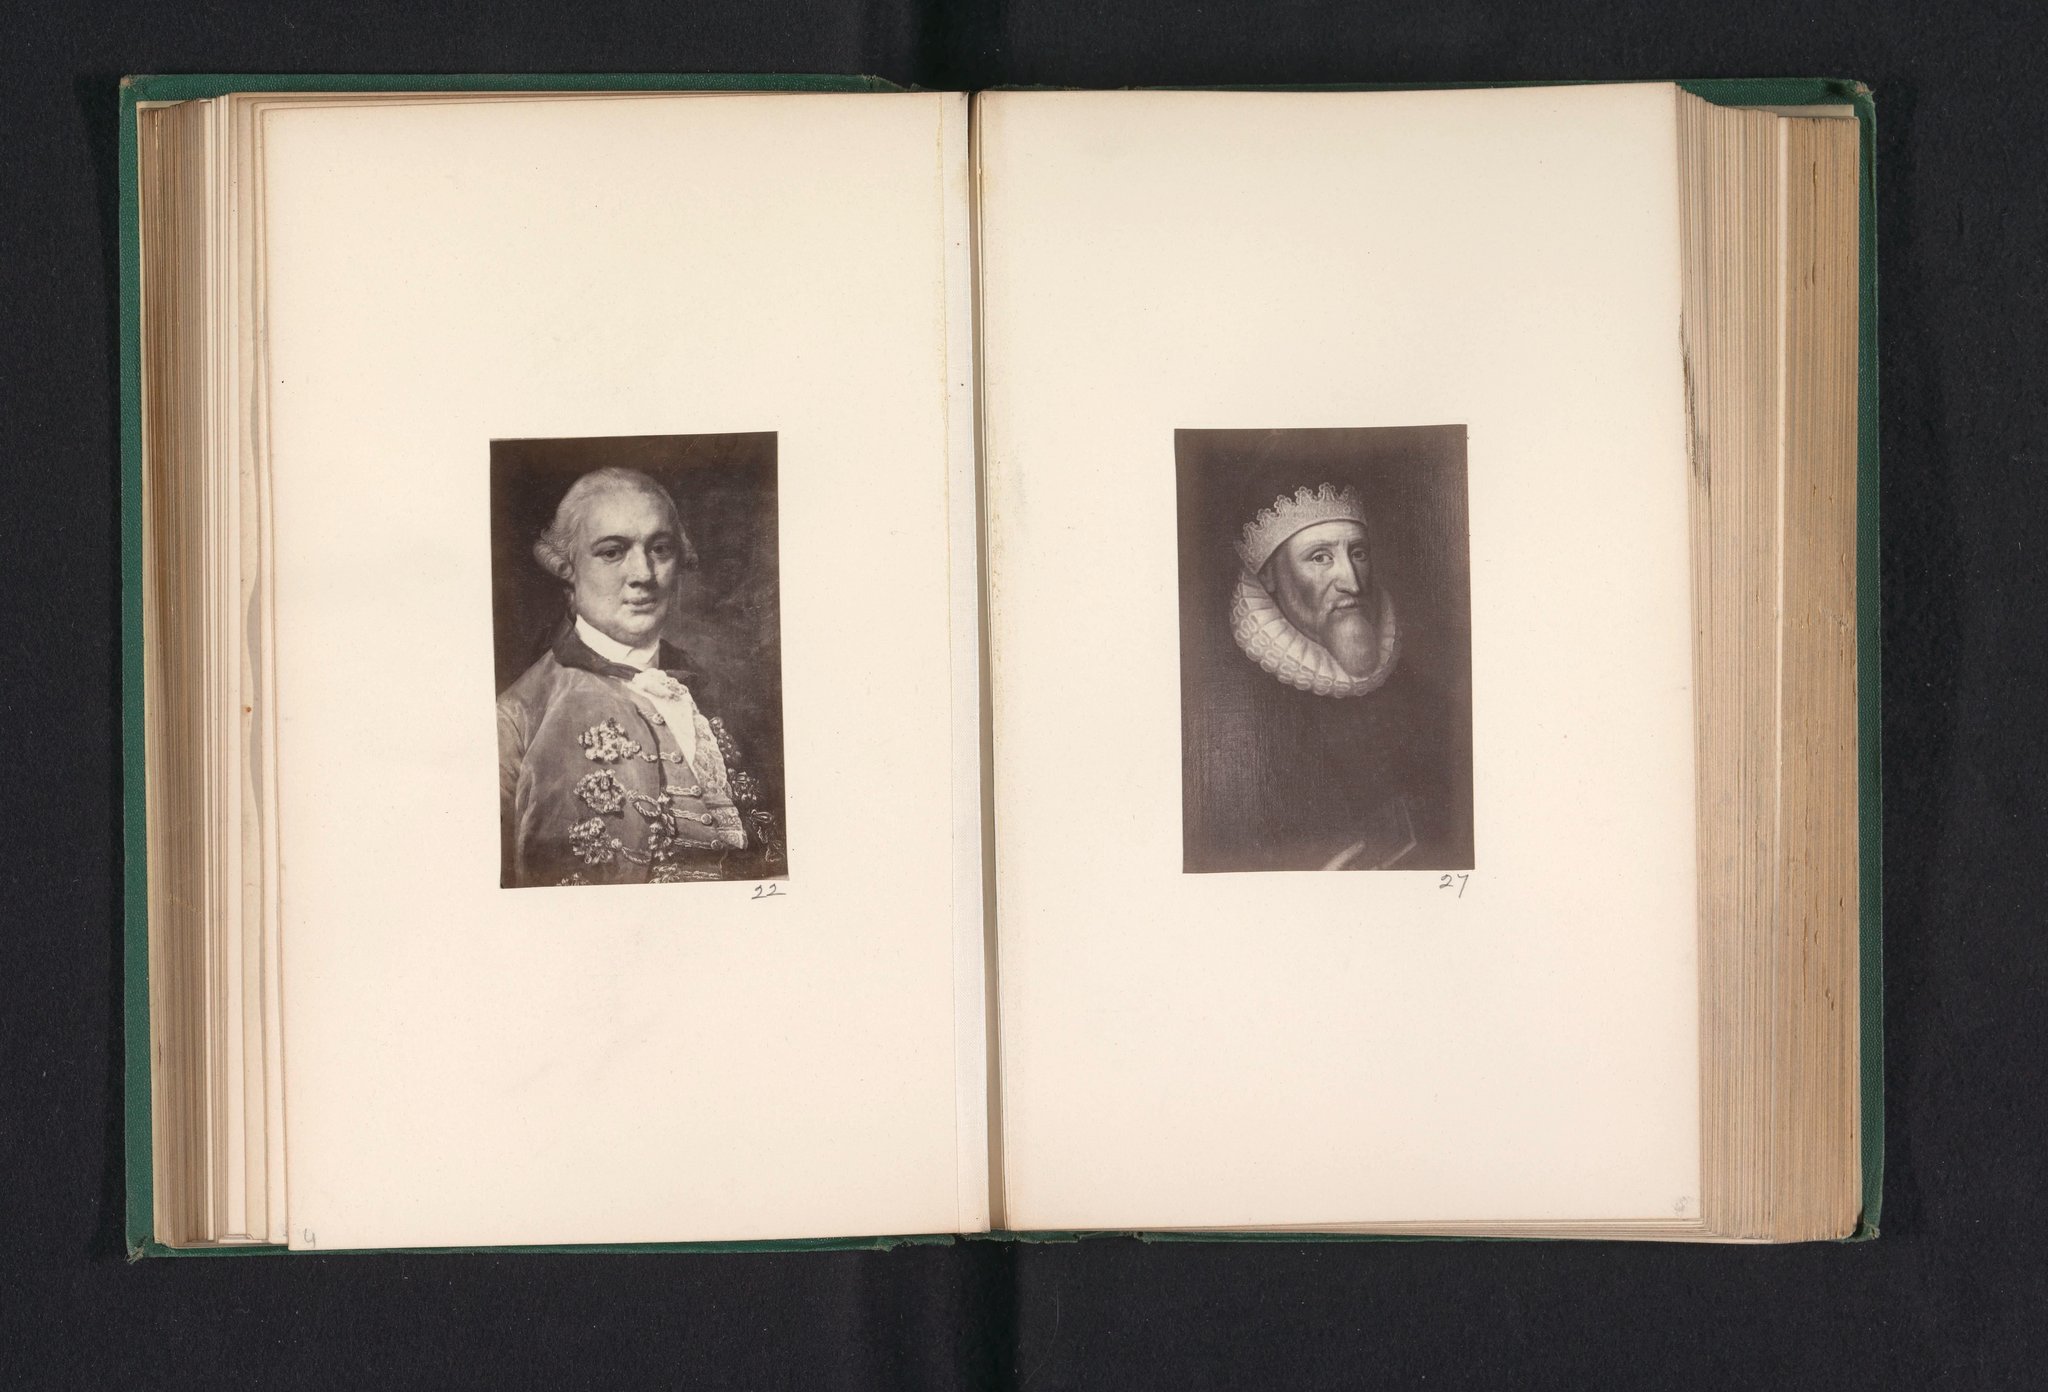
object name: photograph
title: Fotoreproductie van een schilderij, voorstellende een portret van Robert Bell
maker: thomas annan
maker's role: fotograaf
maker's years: 1829-1887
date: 1863-1868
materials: photographic support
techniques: albumen print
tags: historical persons (portraits and scenes from the life) (+ (full) bust portrait)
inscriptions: number: ‘27’